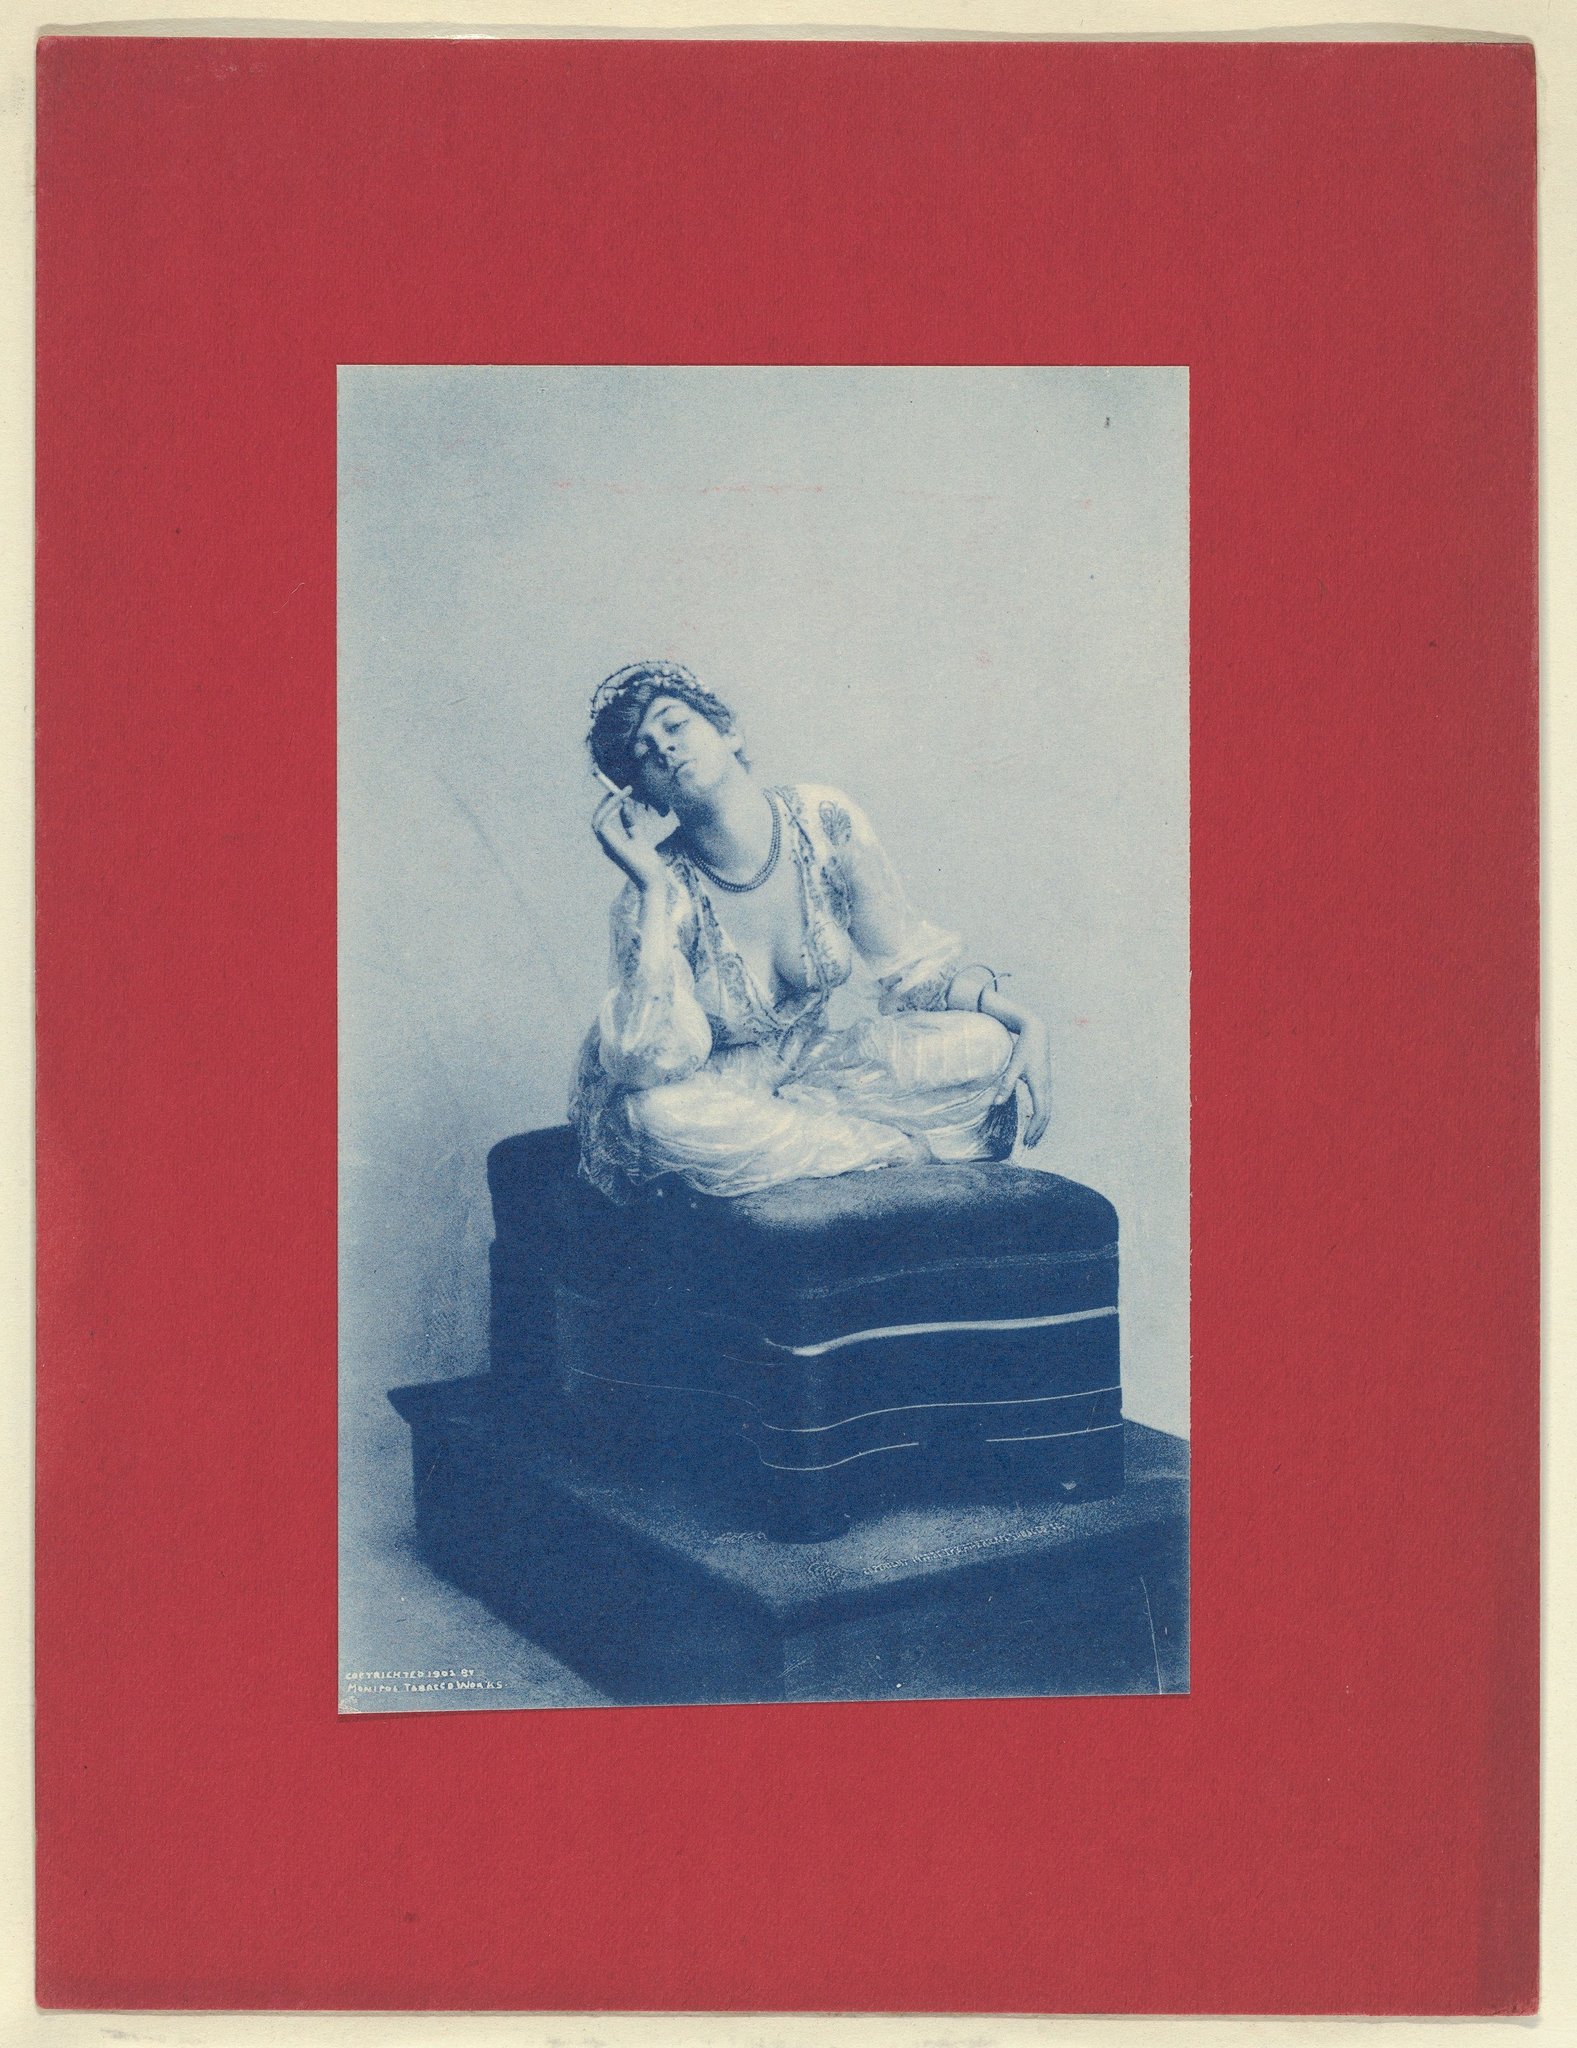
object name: print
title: Plate 9, from Little Egypt Actresses series (T2), issued by Monopole Tobacco Works to promote Khedive Egyptian Cigarettes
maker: monopole tobacco works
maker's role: publisher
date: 1902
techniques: photolithograph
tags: portraits,women,actresses